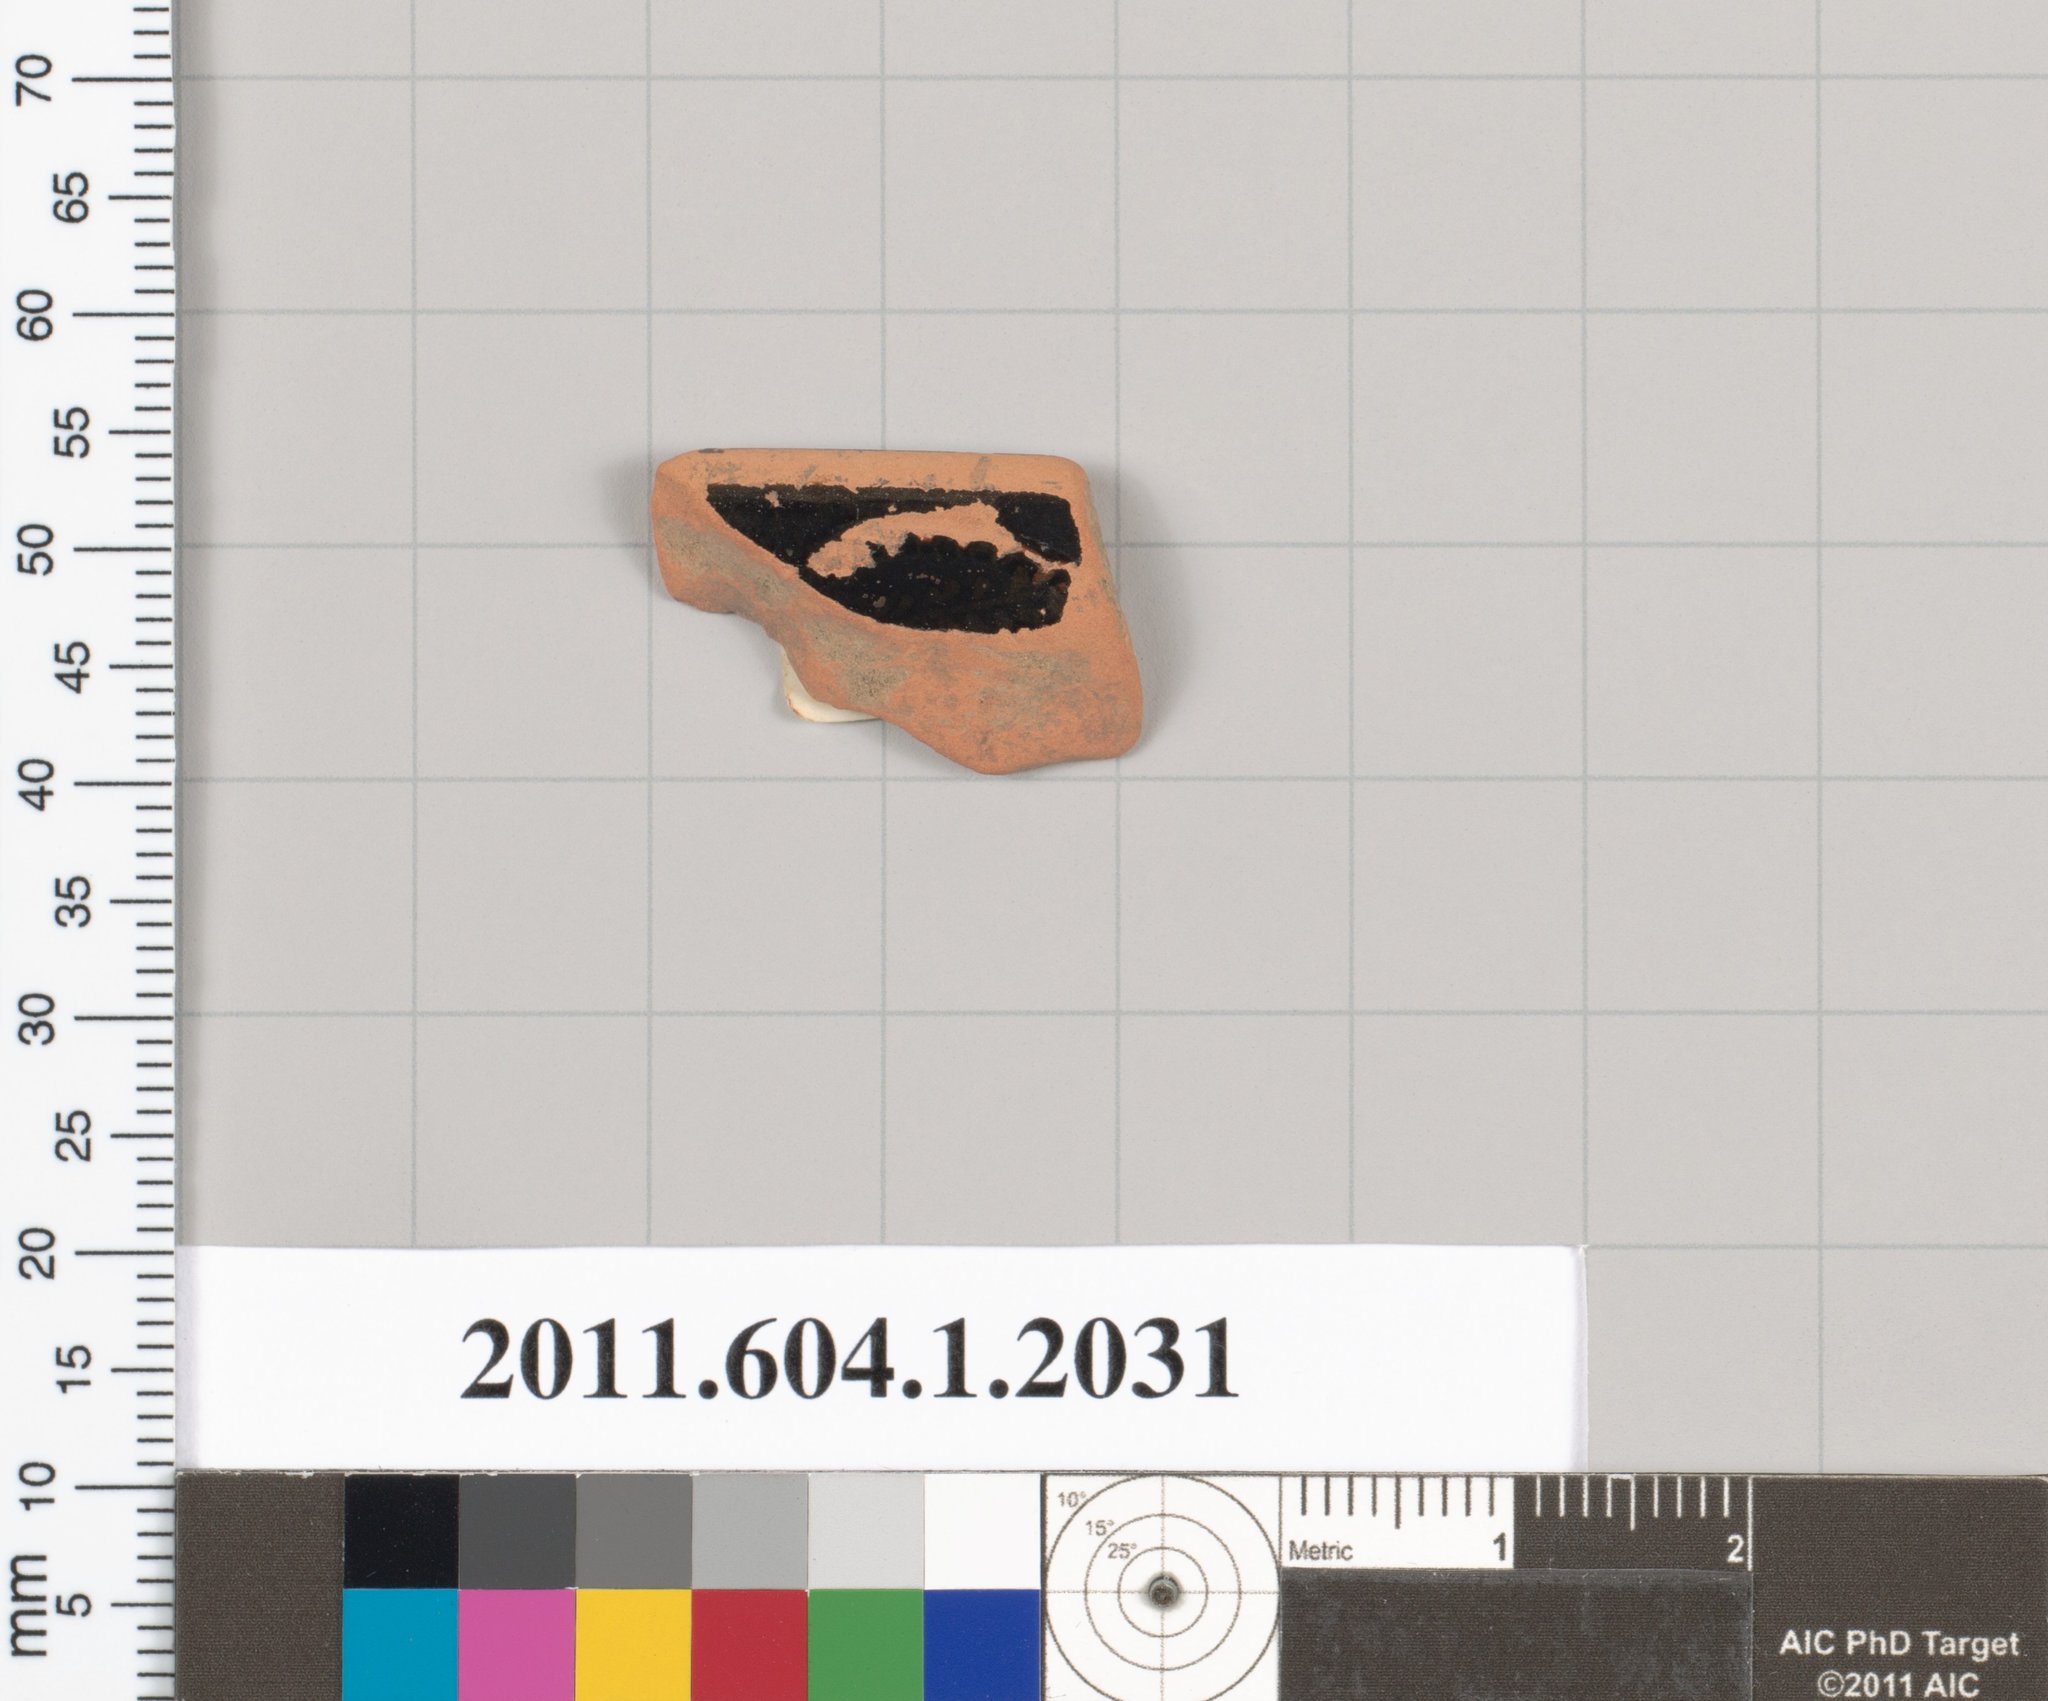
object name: kylix fragment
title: Terracotta rim fragment of a kylix (drinking cup)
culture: greek, attic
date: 534-468 BCE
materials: terracotta